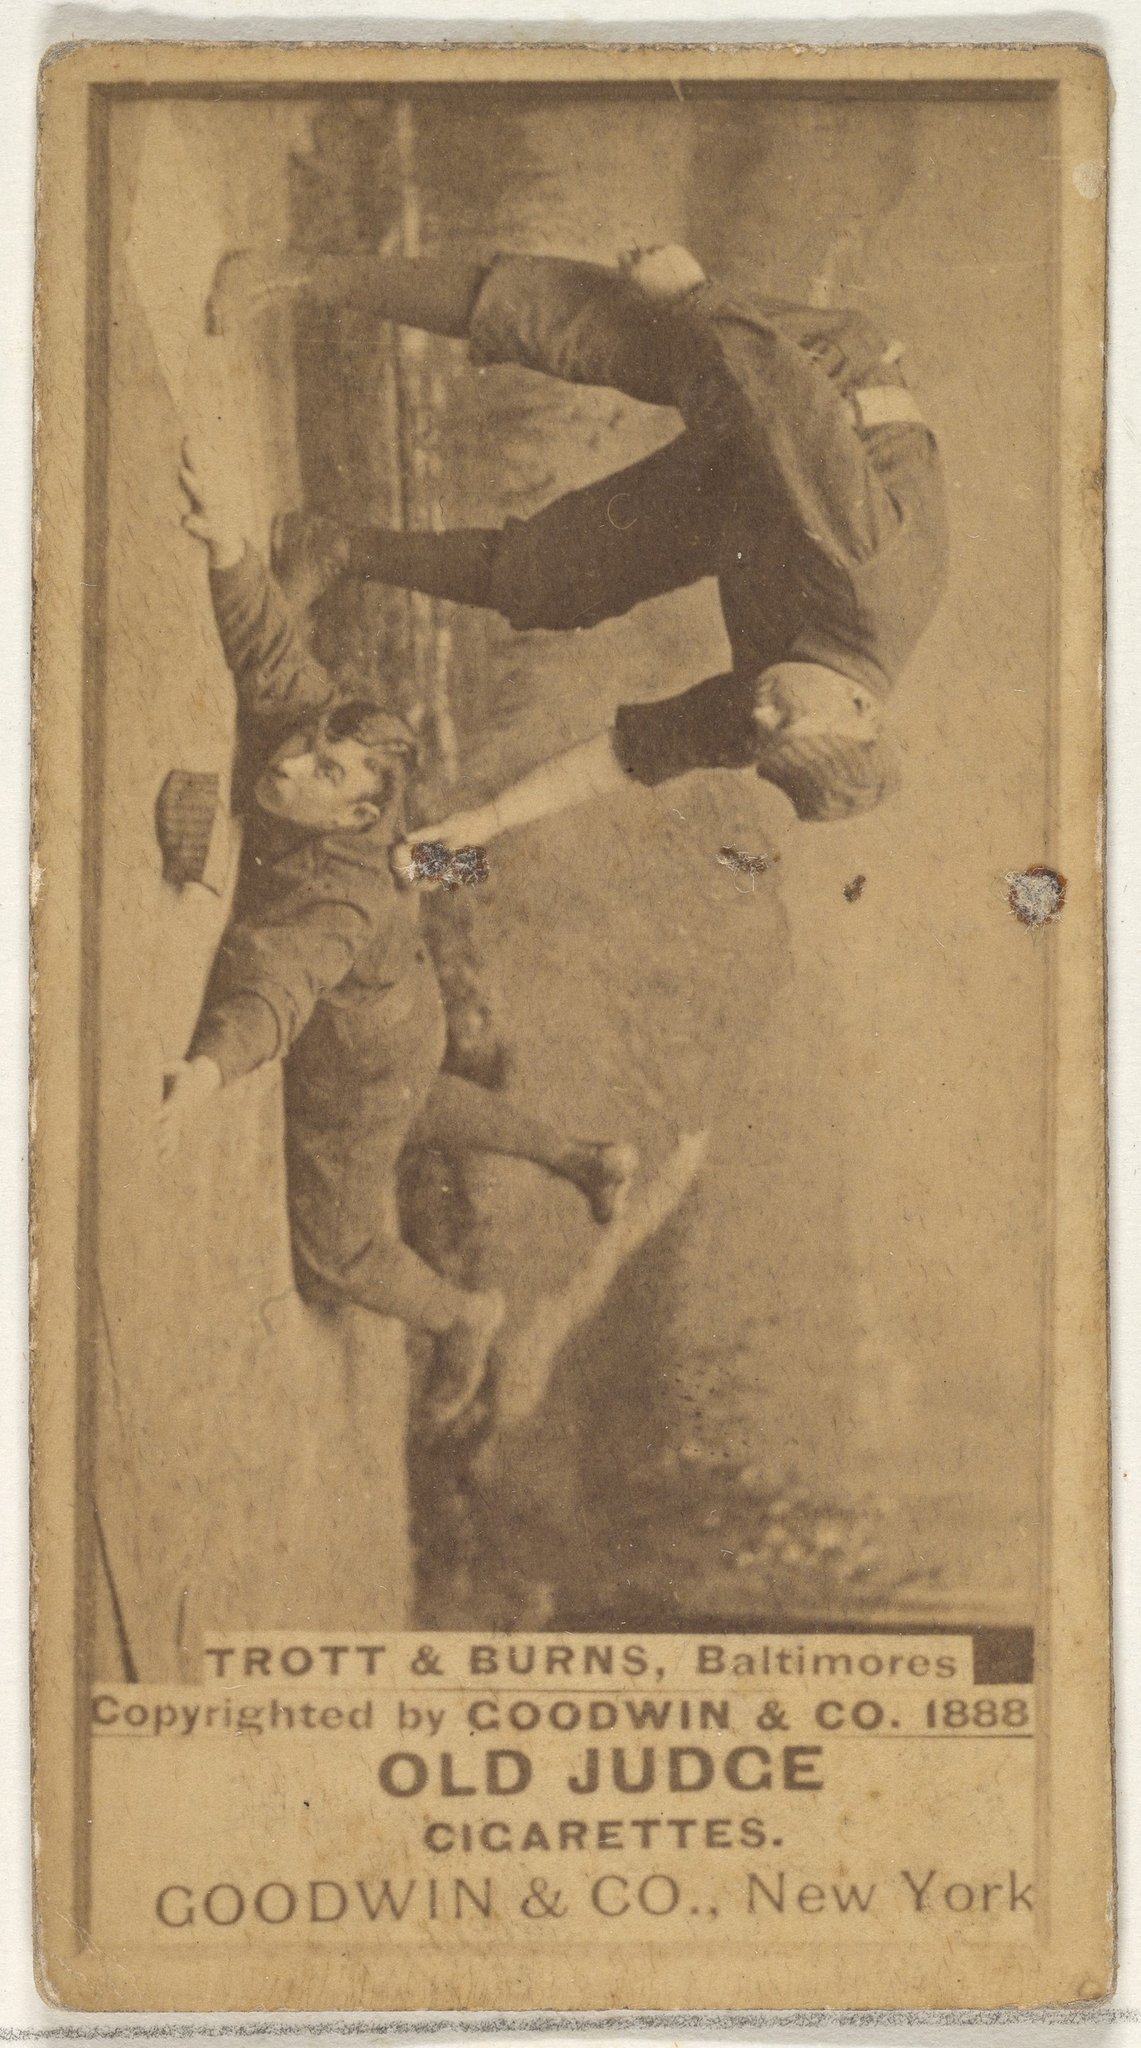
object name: baseball card, photograph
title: Trott and Burns, Baltimore Orioles, from the Old Judge series (N172) for Old Judge Cigarettes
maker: goodwin & company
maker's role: publisher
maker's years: 1850-1950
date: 1888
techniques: albumen silver print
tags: men,portraits,baseball,athletes